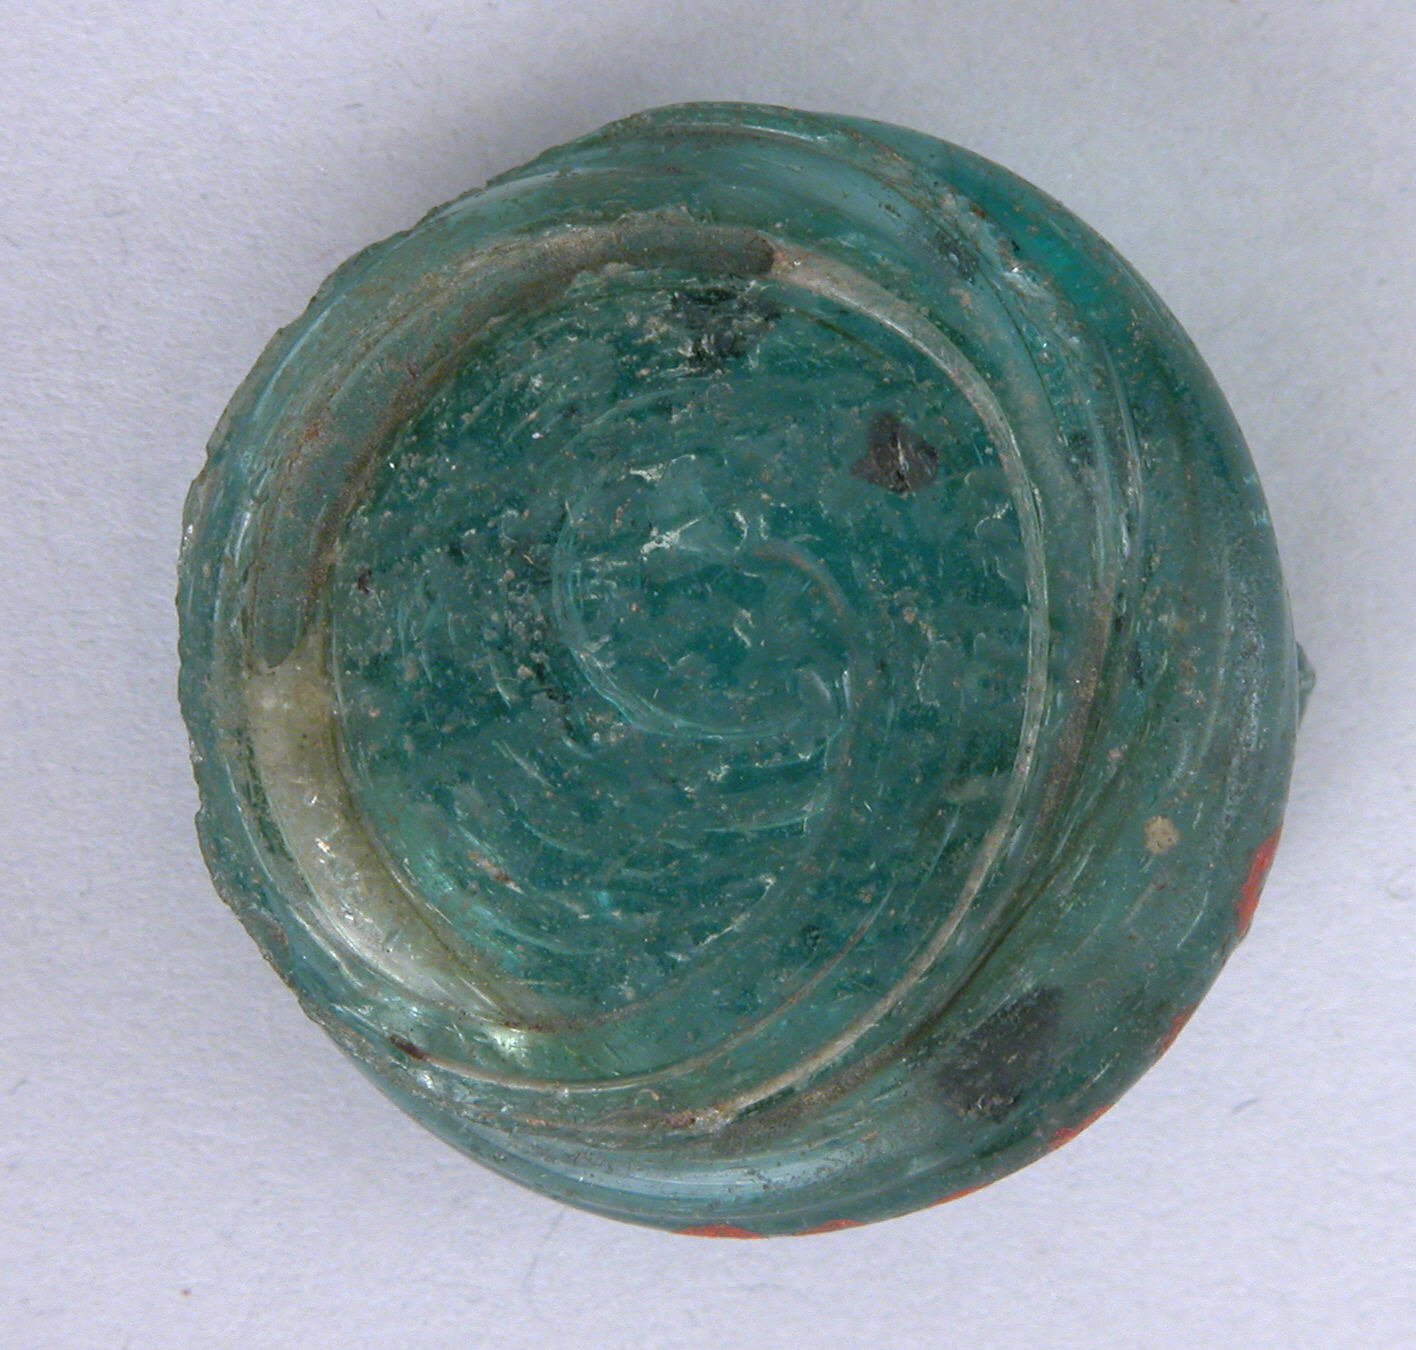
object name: vessel stamp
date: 701-800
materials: glass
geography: egypt